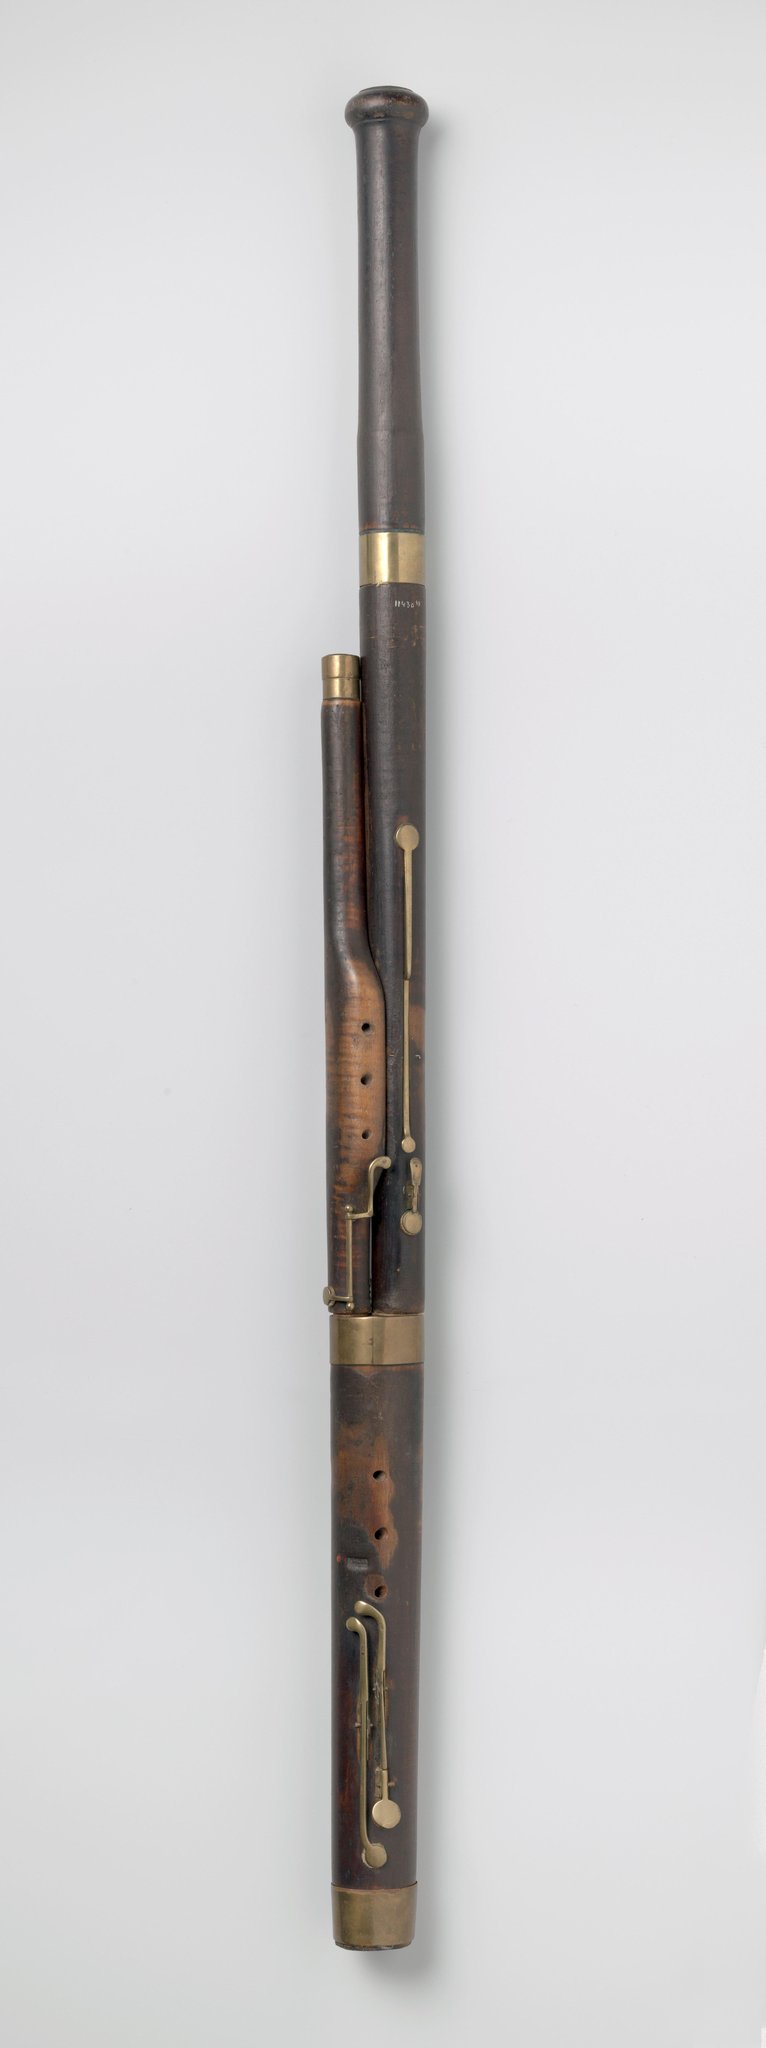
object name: bassoon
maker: august friedrich andreas knochenhauer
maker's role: musical instrument maker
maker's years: 1796-1866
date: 1855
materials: wood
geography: berlin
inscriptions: stamp: ‘Knochenhauer/ Berlin […]’